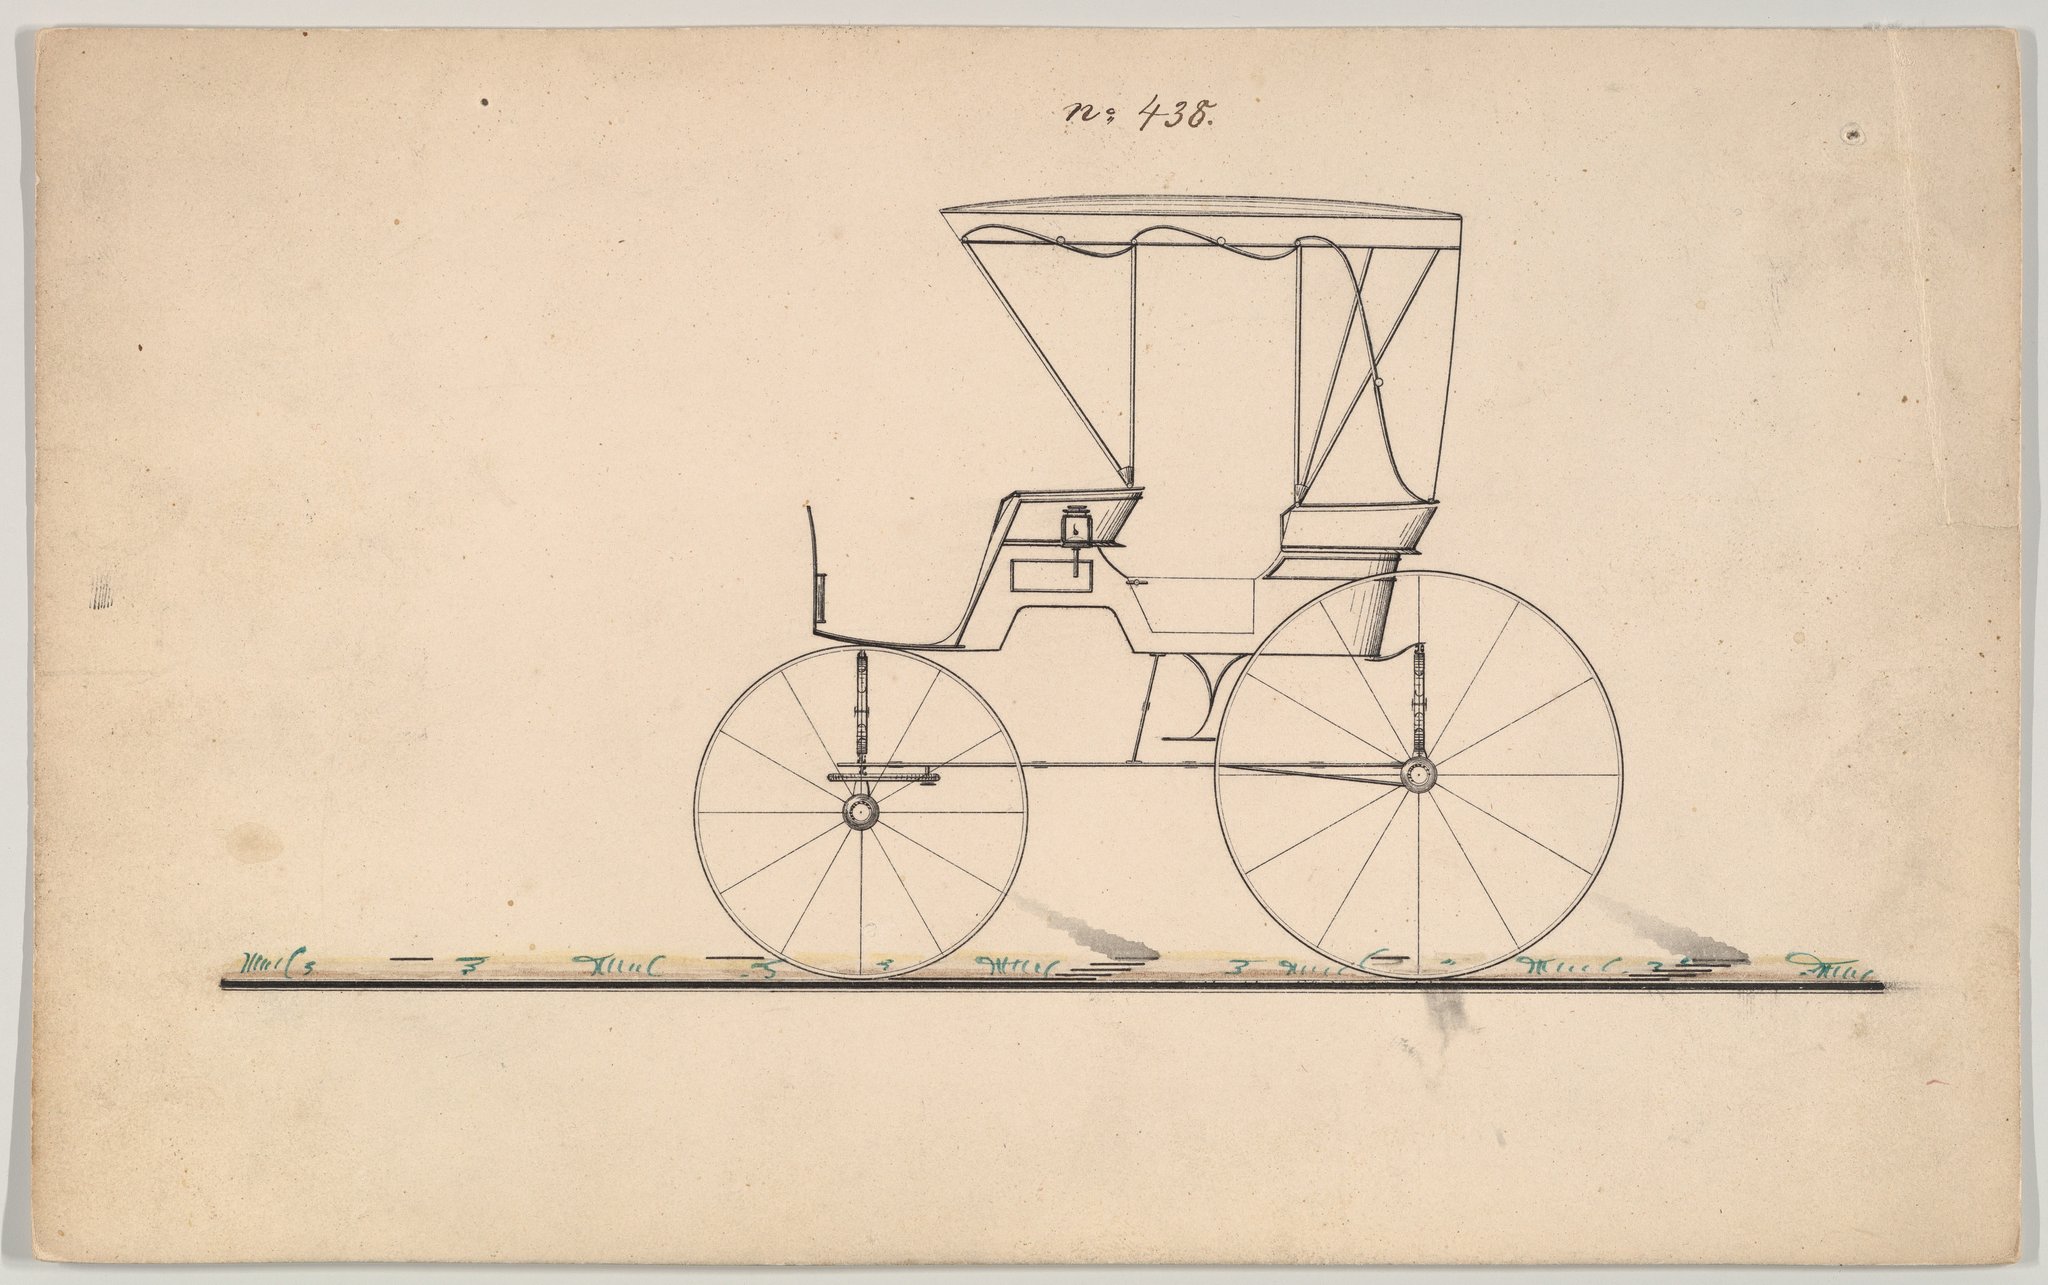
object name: drawing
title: Extension Top Phaeton #438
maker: brewster & co.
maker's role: manufacturer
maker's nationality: american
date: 1865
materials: gouache, ink, watercolor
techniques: pen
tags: carriages